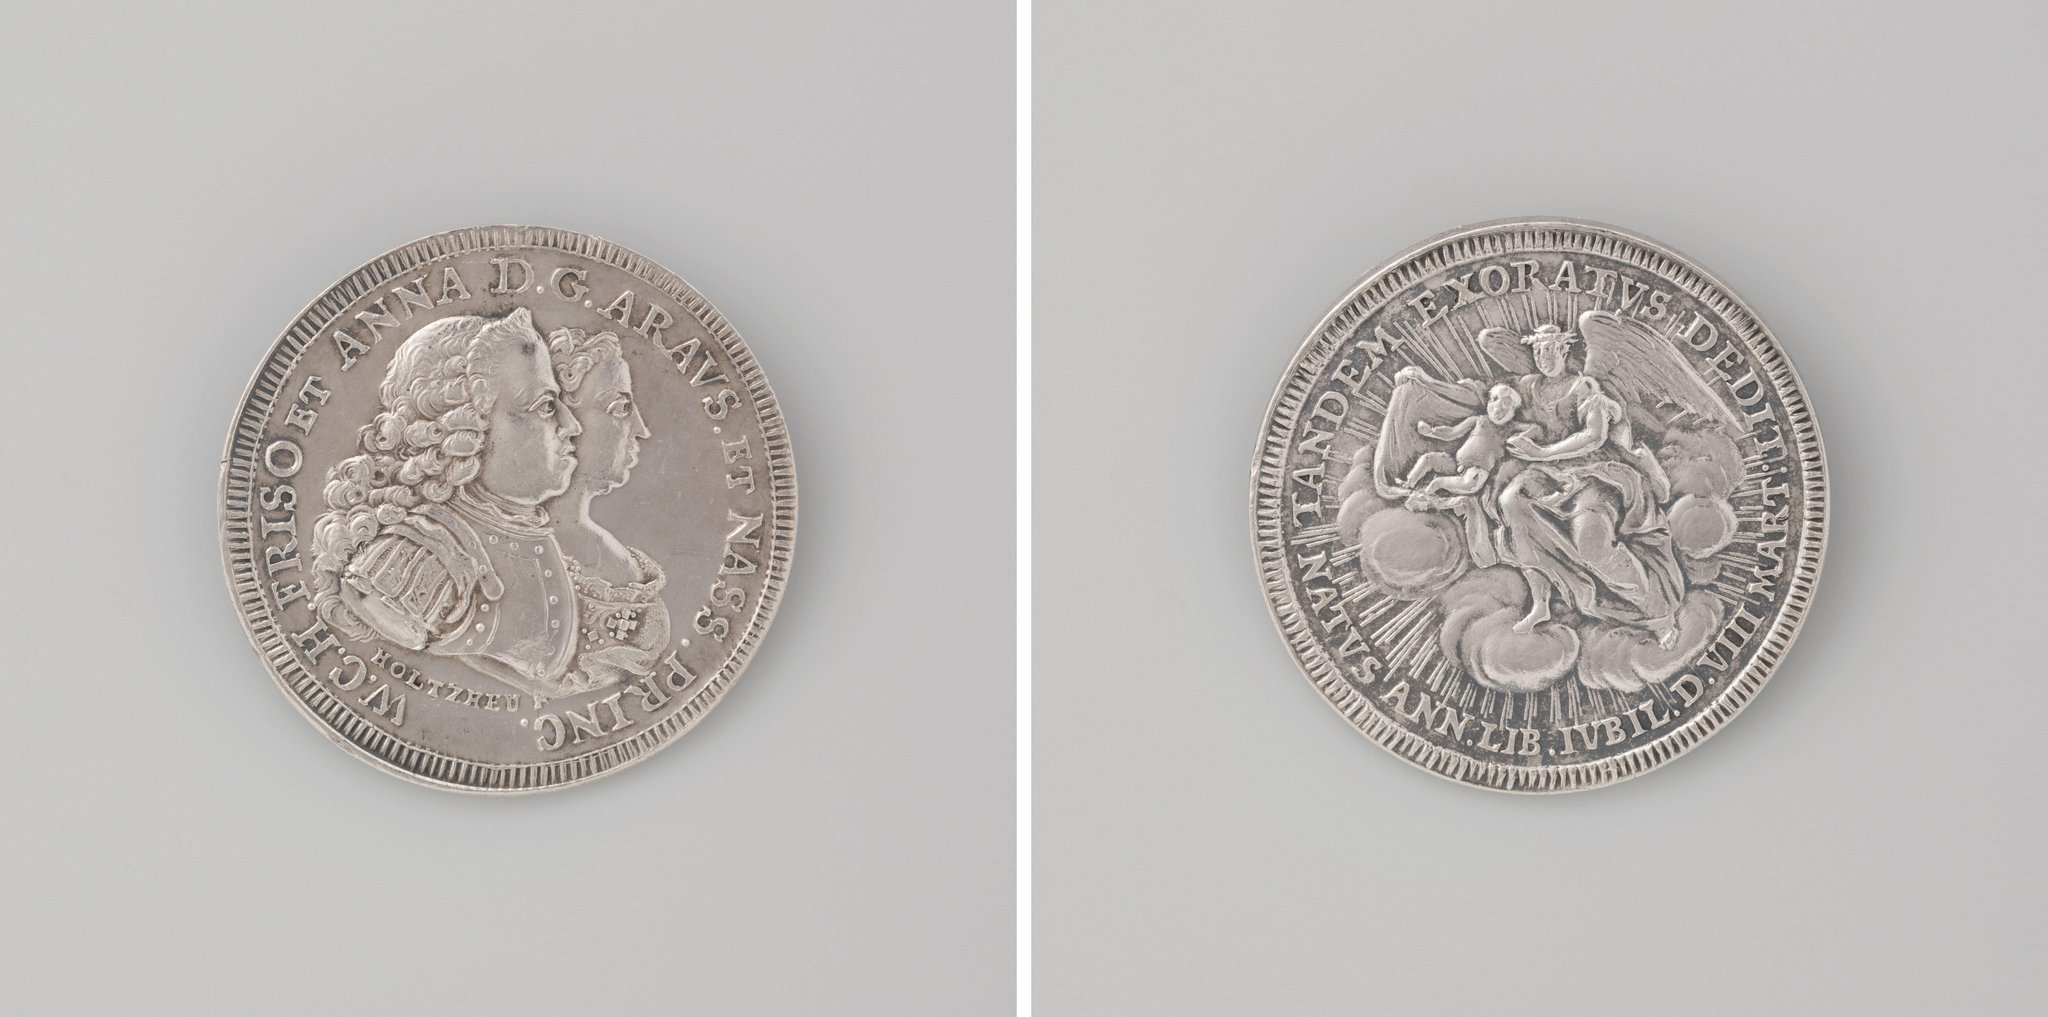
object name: history medal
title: Geboorte van prins Willem, zoon van Willem IV en Anna van Hannover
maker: martinus holtzhey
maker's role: medailleur, muntmaker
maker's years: 1697-1764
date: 1748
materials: silver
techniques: striking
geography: amsterdam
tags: the hague, william v (prince of orange), anna van hannover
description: Zilveren penning. Voorzijde: borststuk man en vrouw binnen omschrift. Keerzijde: engel, zittend op wolk en omgeven door een stralenkrans, houdt de pas geboren prins op een kleed binnen omschrift